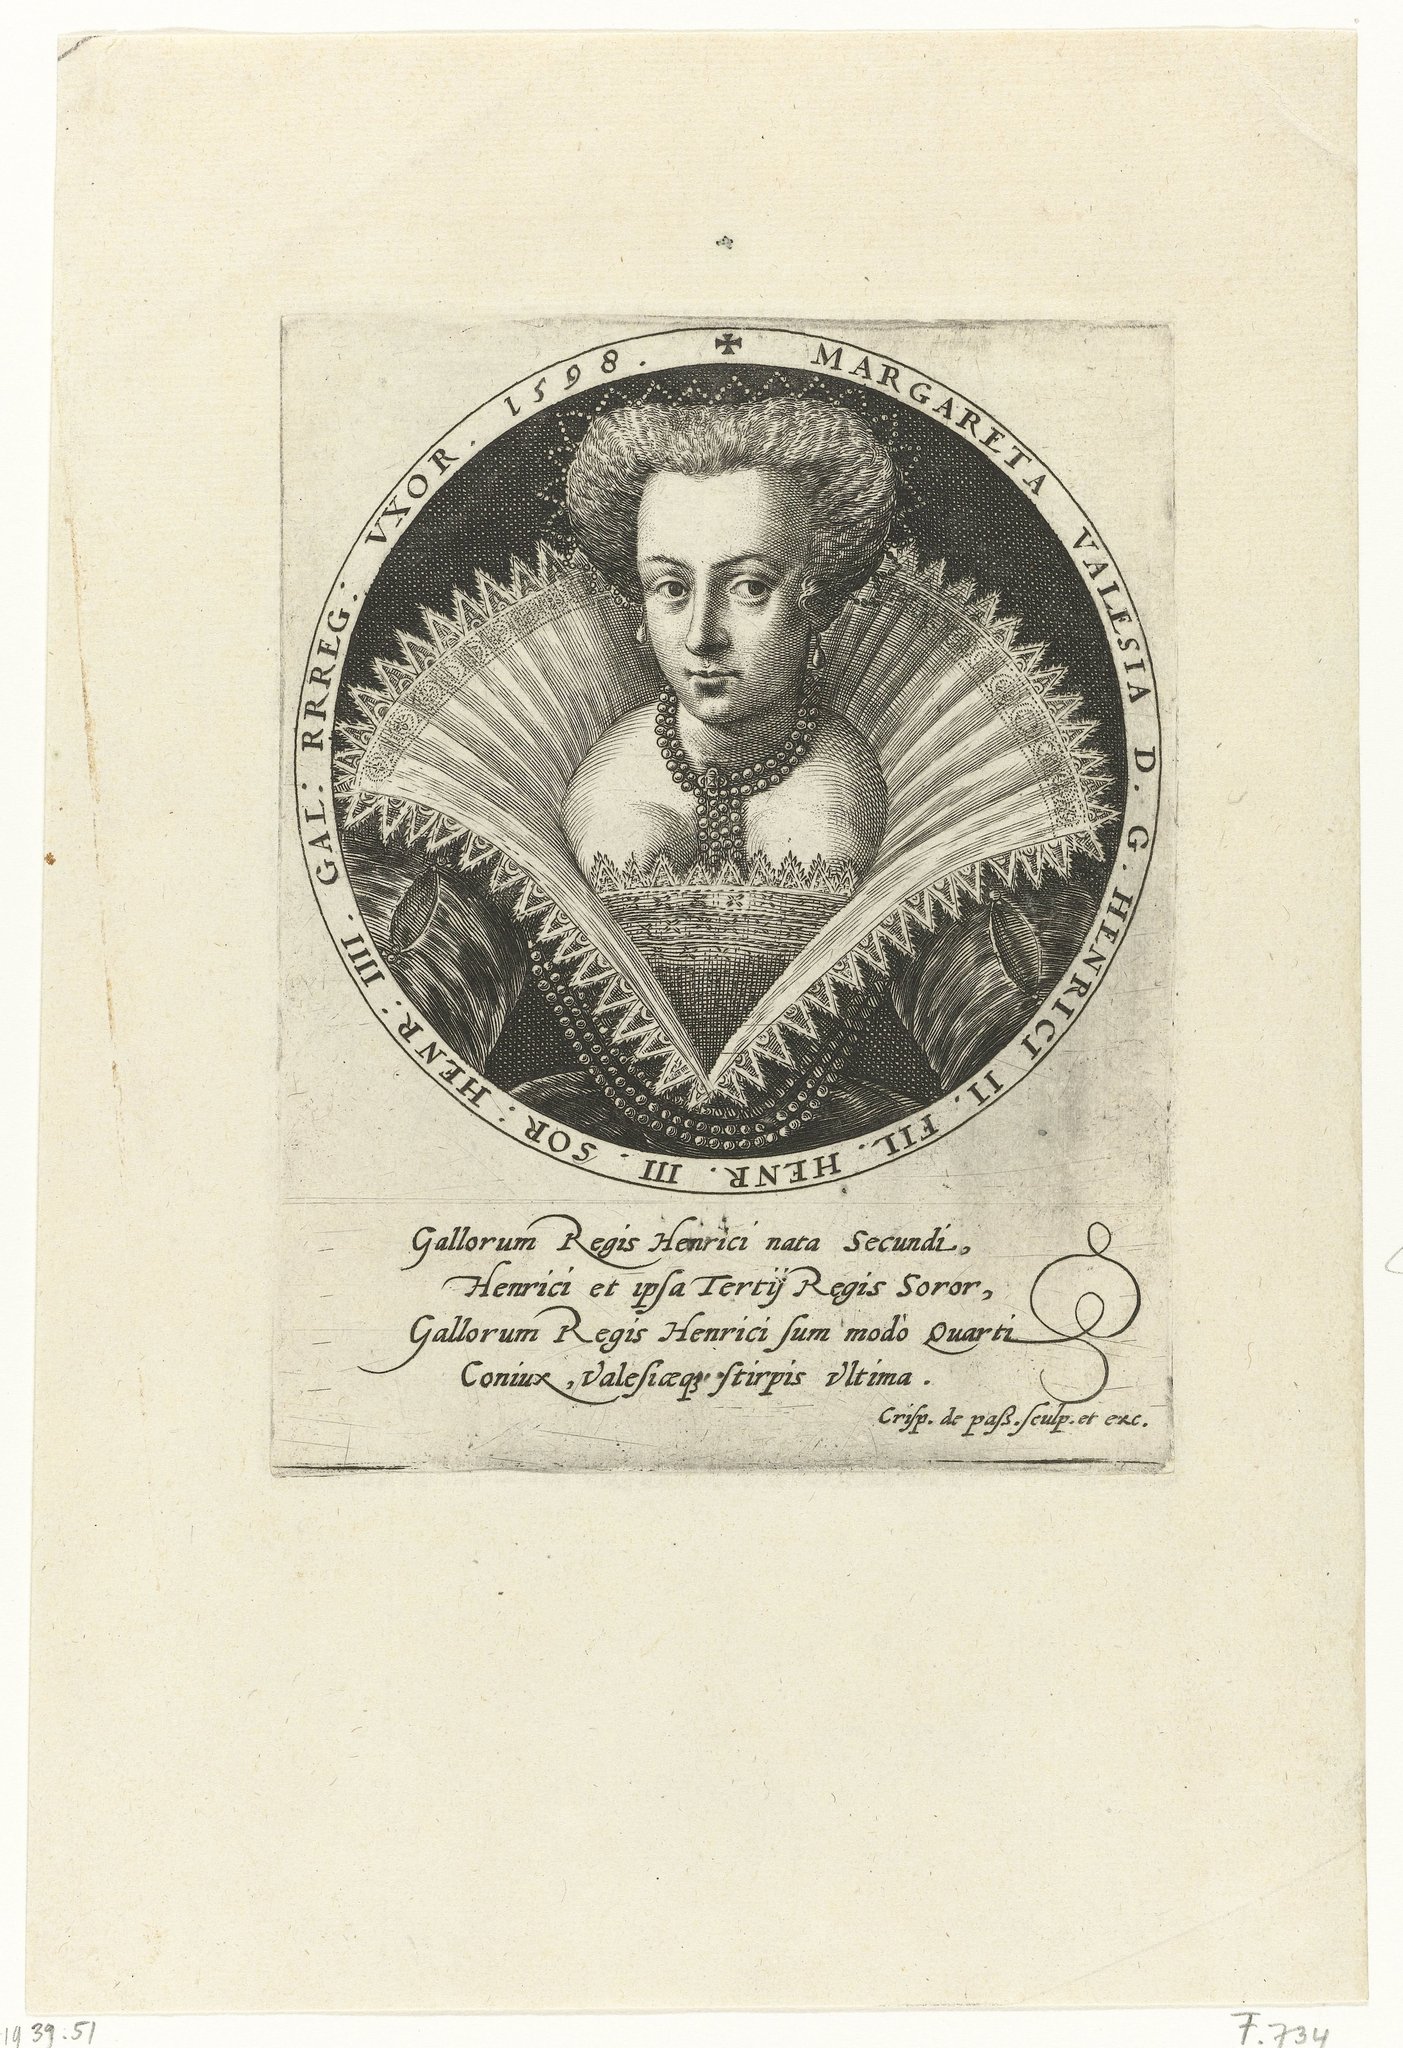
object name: print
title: Portret van Margaretha van Valois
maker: crispijn van de passe (i)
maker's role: draughtsman, print maker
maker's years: 1564-1637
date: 1598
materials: paper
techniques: engraving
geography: cologne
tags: historical persons - bb - woman, queen, empress, etc. (wife of a ruler), neck-gear: collar (+ women's clothes), ear-rings, pearl; pearl necklace (+ women's clothes)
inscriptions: date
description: Kleding: hoog opstaande kraag met kant, decolleté bedekt; parelkettingen om de hals, oorbellen.